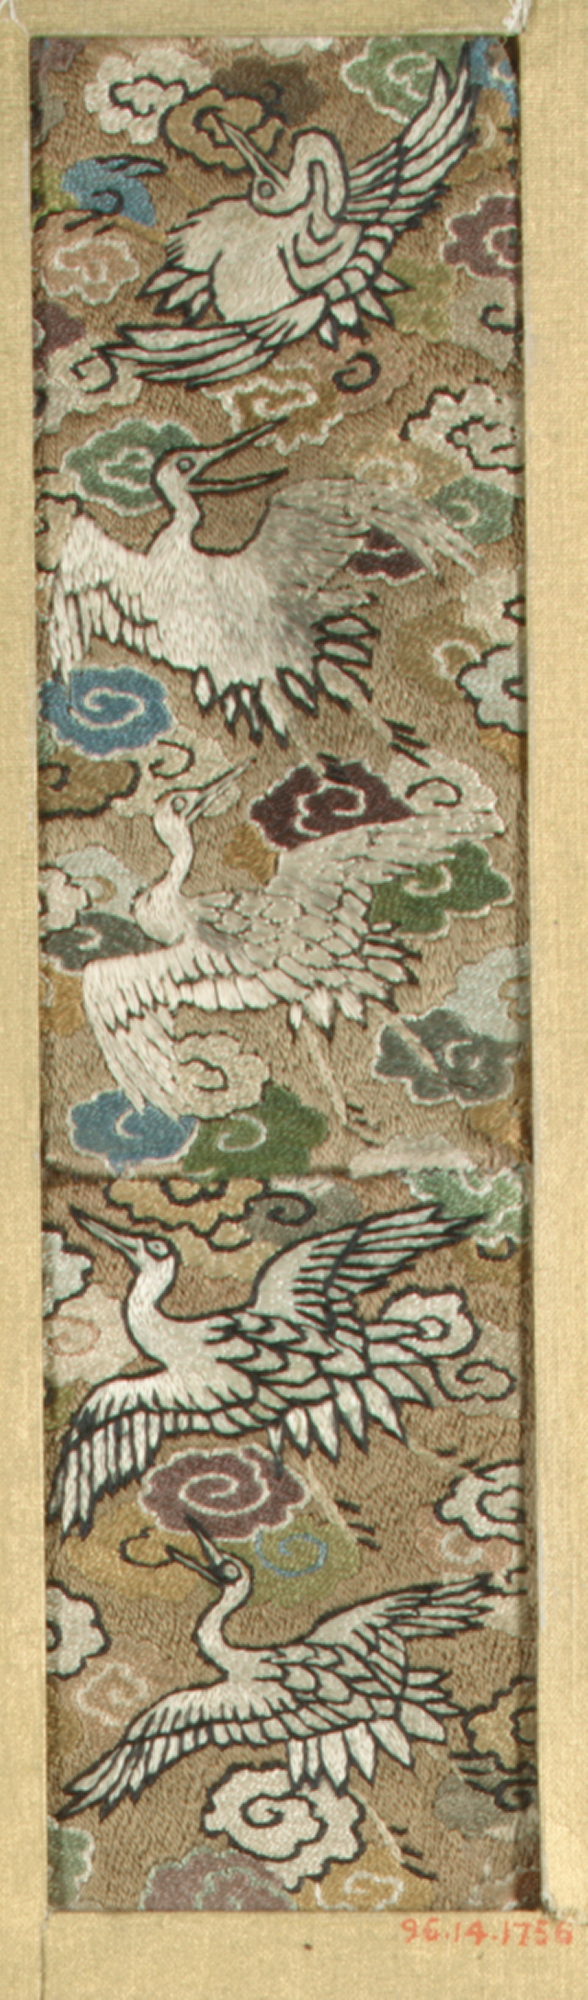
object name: piece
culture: japanese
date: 1701-1900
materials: silk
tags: cranes